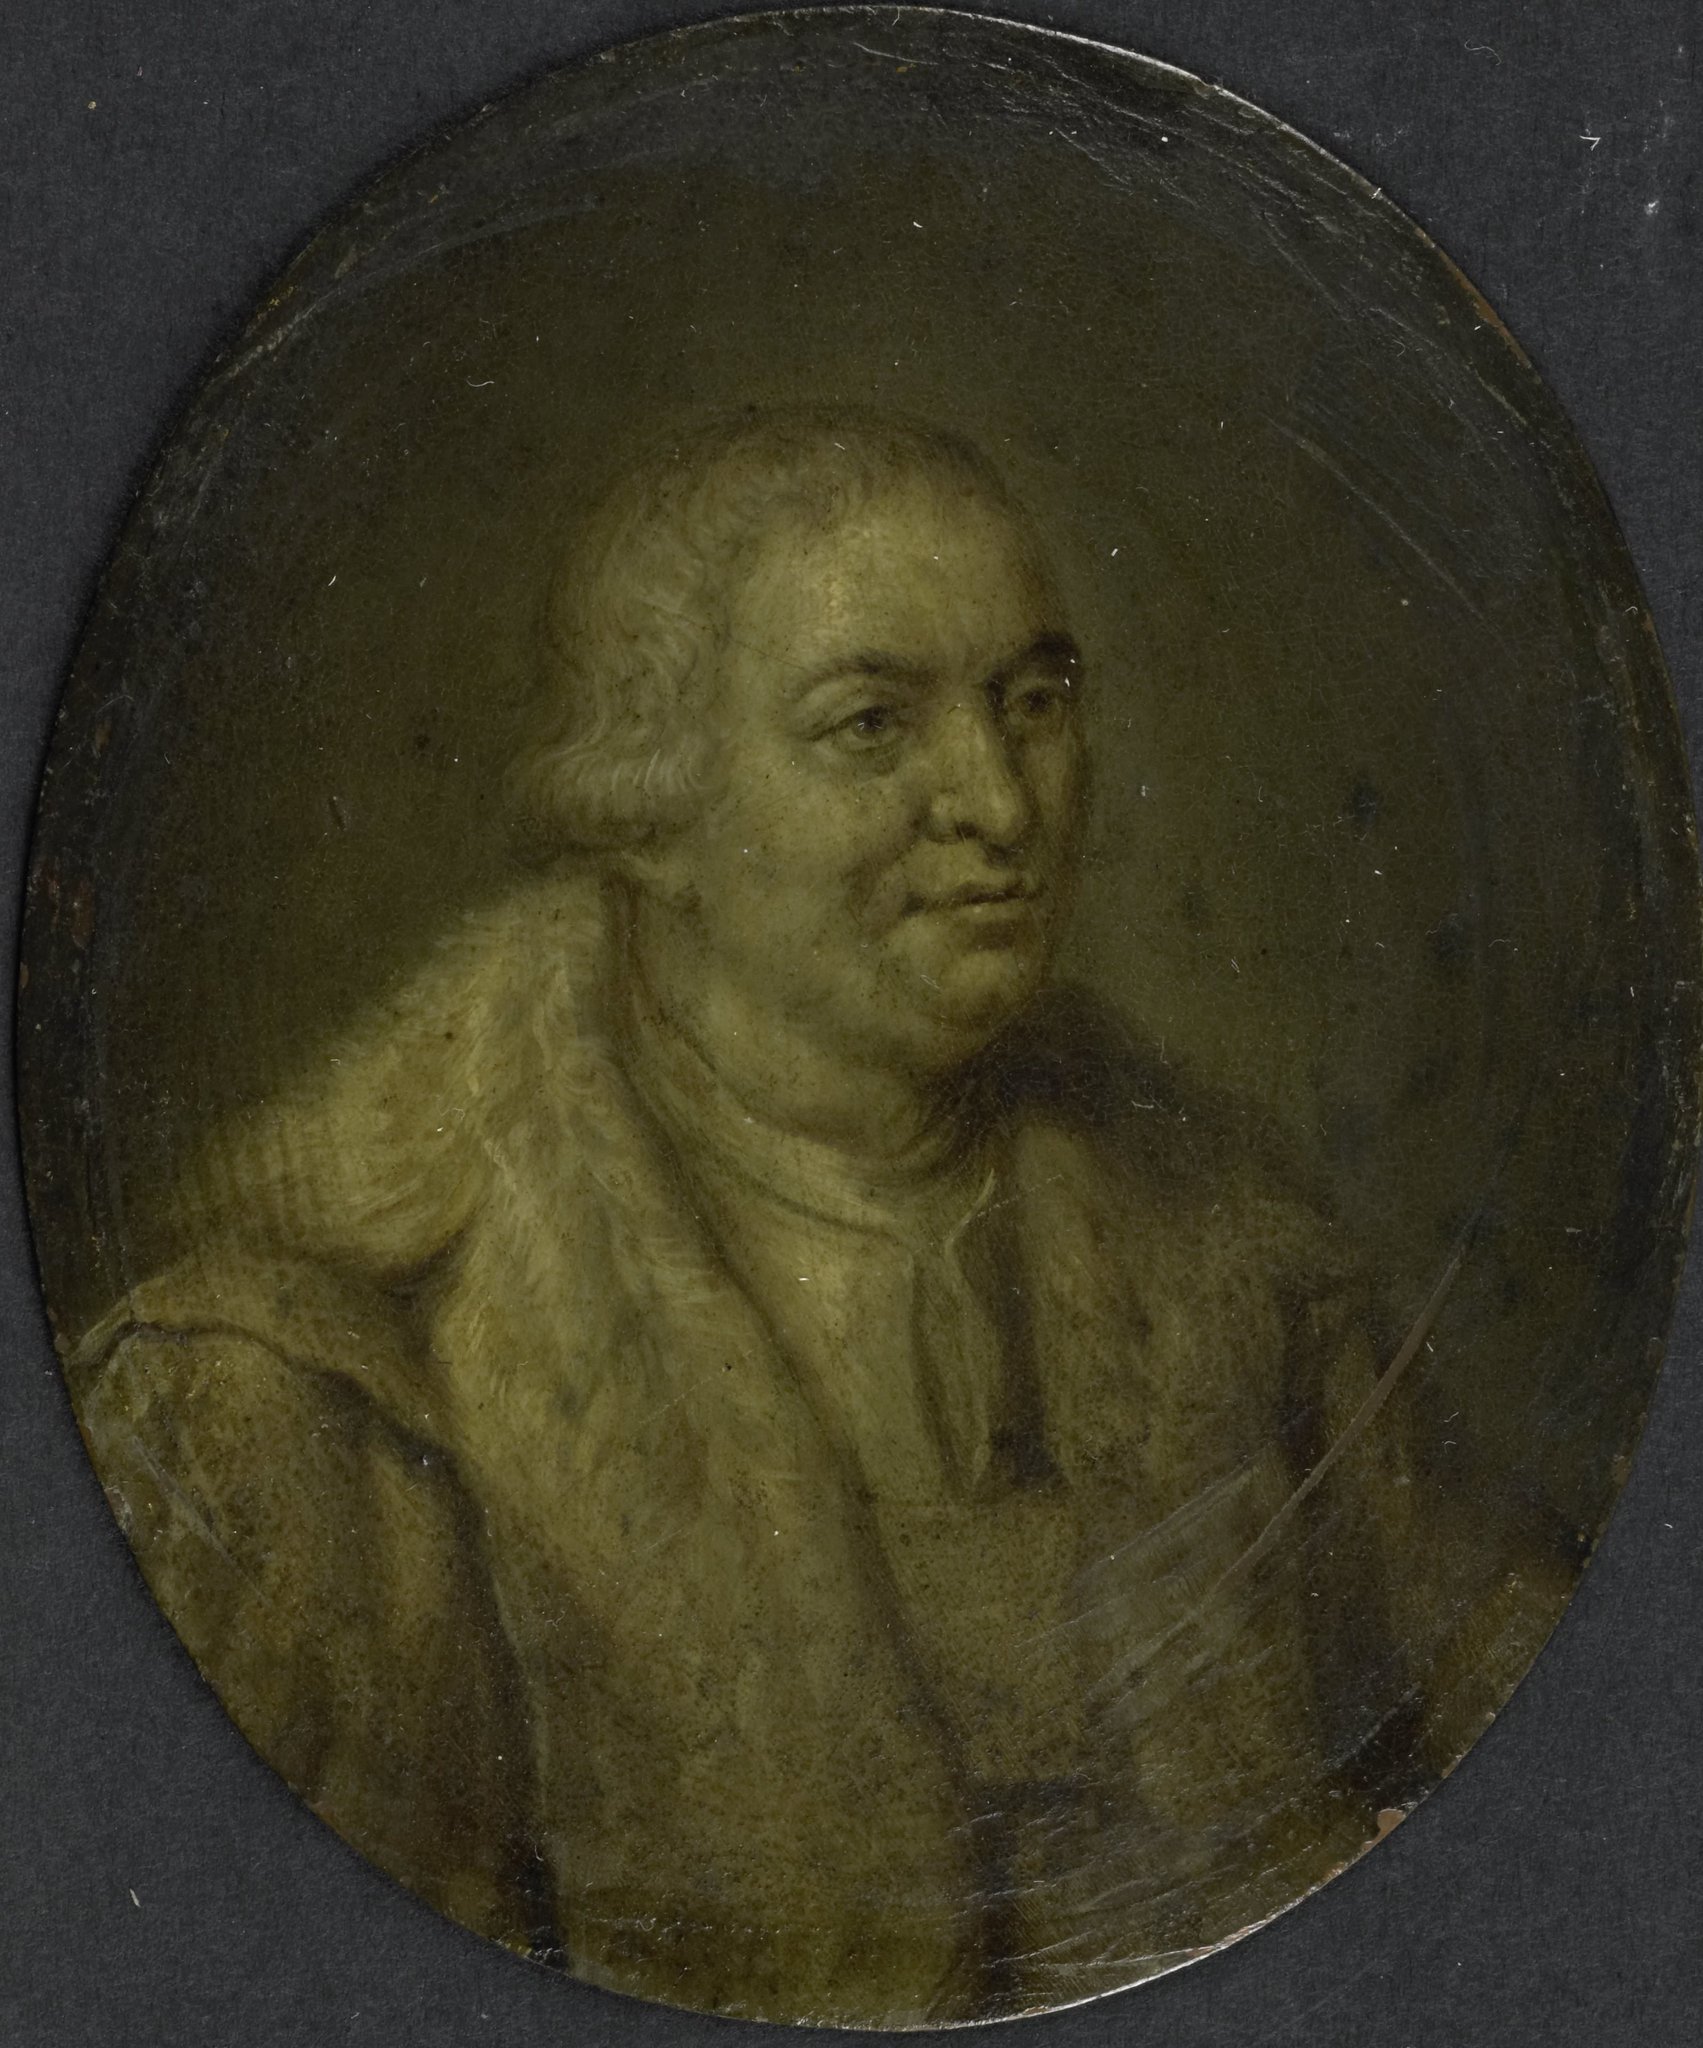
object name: grisaille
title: Jason Pratensis (1486-1558), geneesheer te Zierikzee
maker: jan maurits quinkhard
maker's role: draughtsman, painter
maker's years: 1688-1772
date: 1732-1771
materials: copper, oil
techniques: grisaille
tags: portrait of a writer, writer, poet, author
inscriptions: inscription: ‘Iason Pratensis ob. 1558’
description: Portret van Jason Pratensis (1486-1558). Geneesheer te Zierikzee. Buste in ovaal naar rechts. Vervaardigd naar een onbekend voorbeeld. Onderdeel van een verzameling portretten van Nederlandse dichters.